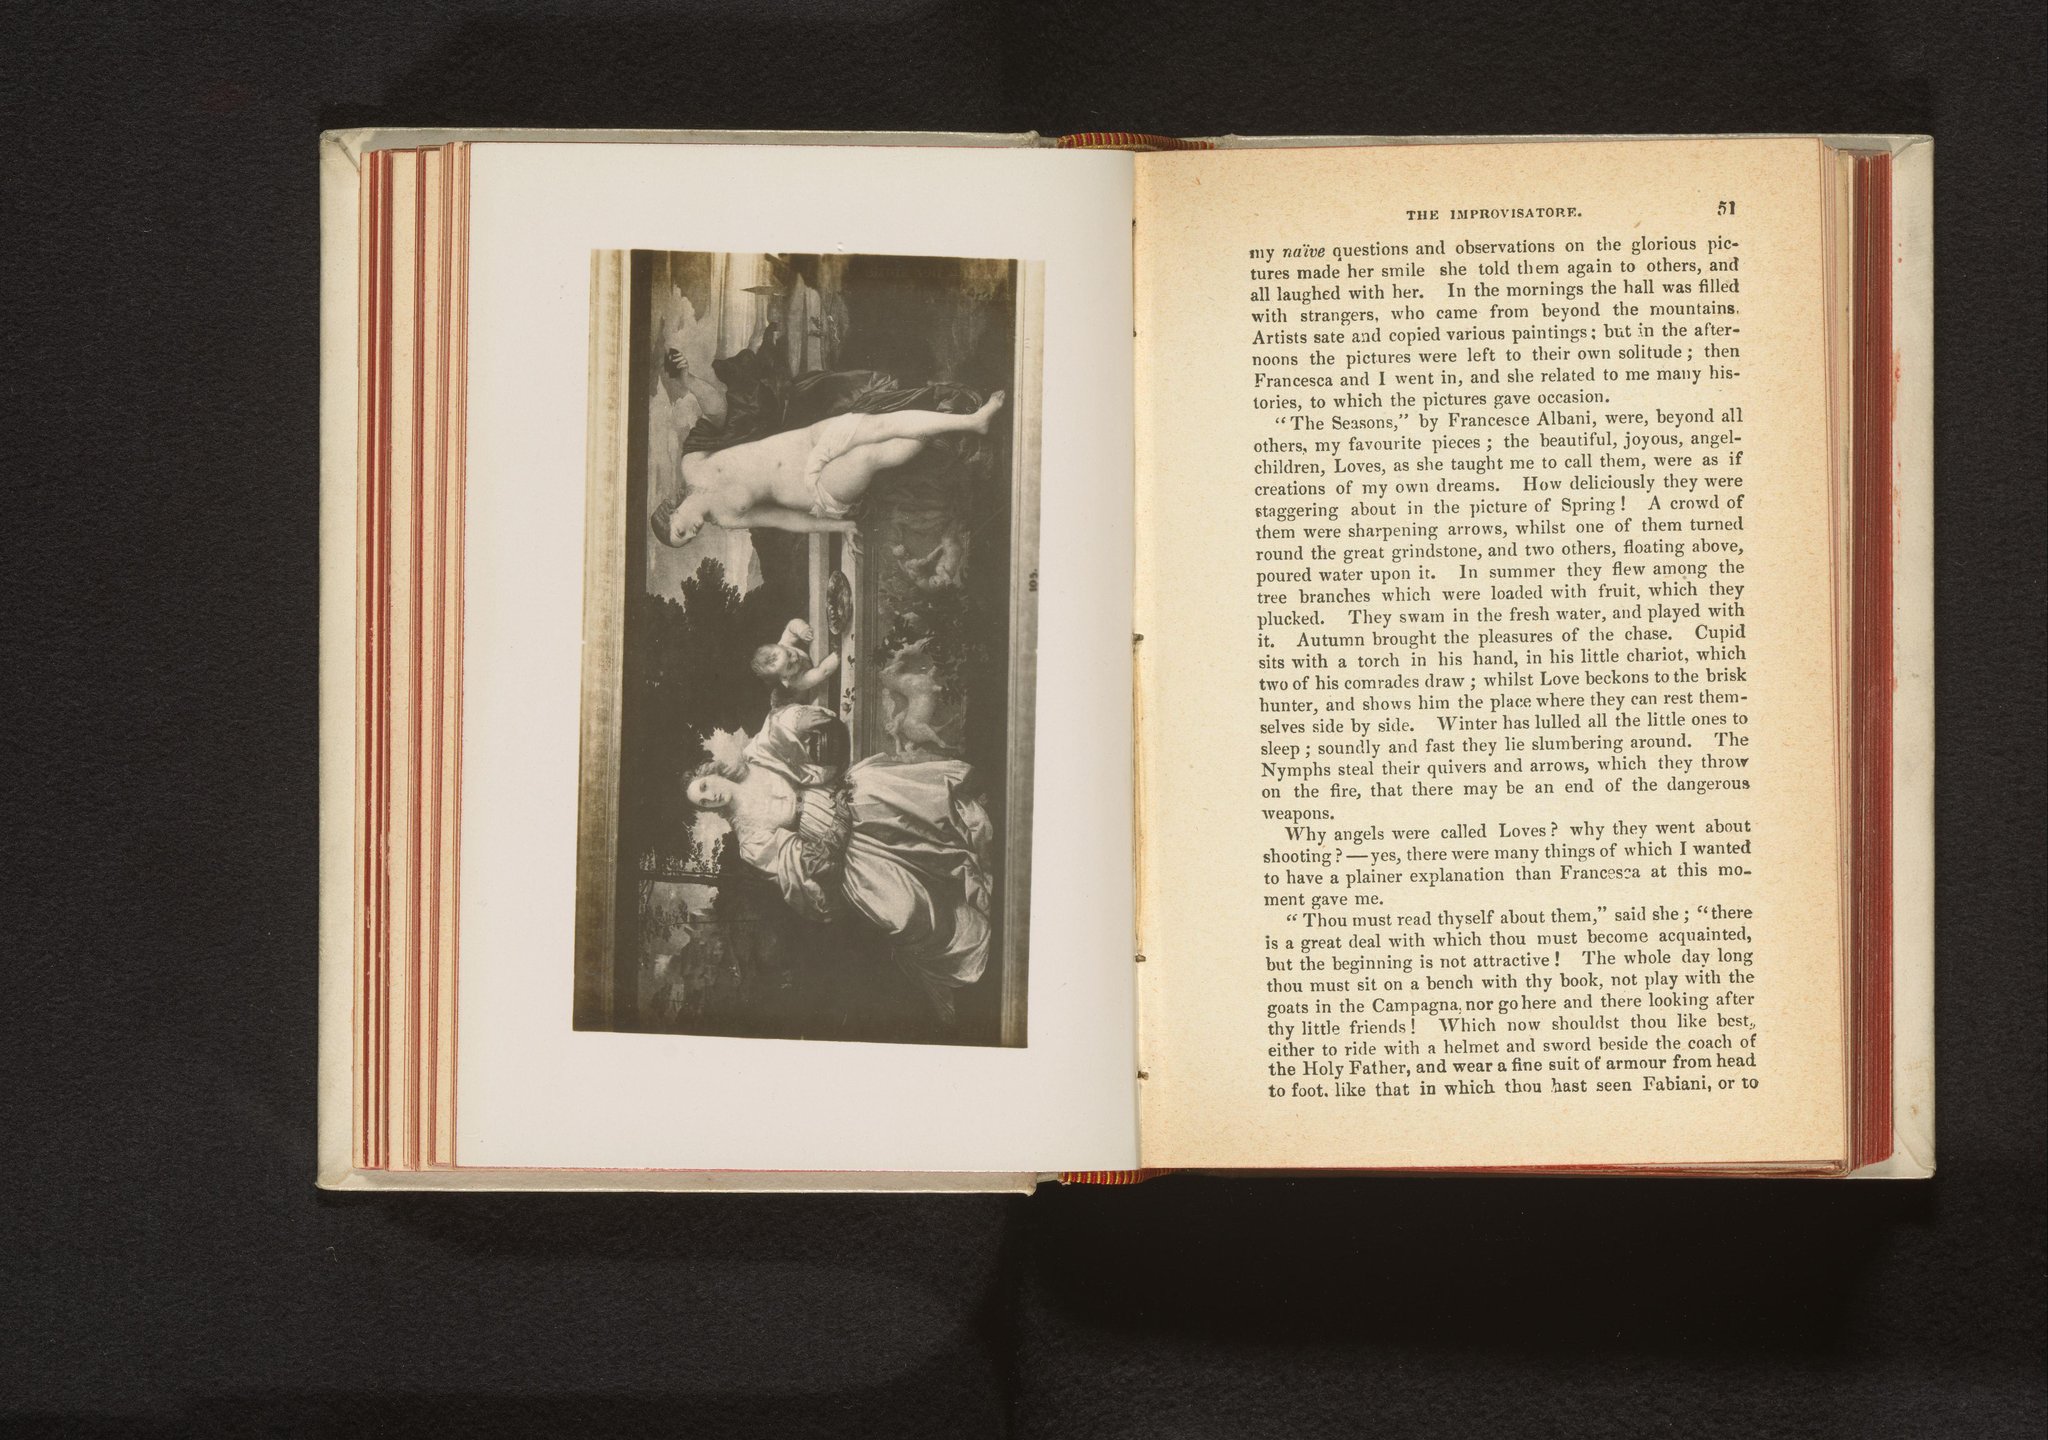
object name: photograph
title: Fotoreproductie van een schilderij, voorstellende de sacrale en profane liefde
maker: Anonymous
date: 1870-1880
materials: photographic support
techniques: gelatin silver print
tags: heavenly love versus earthly love, woman (showing herself) undressed, quasi-nude, sarcophagus